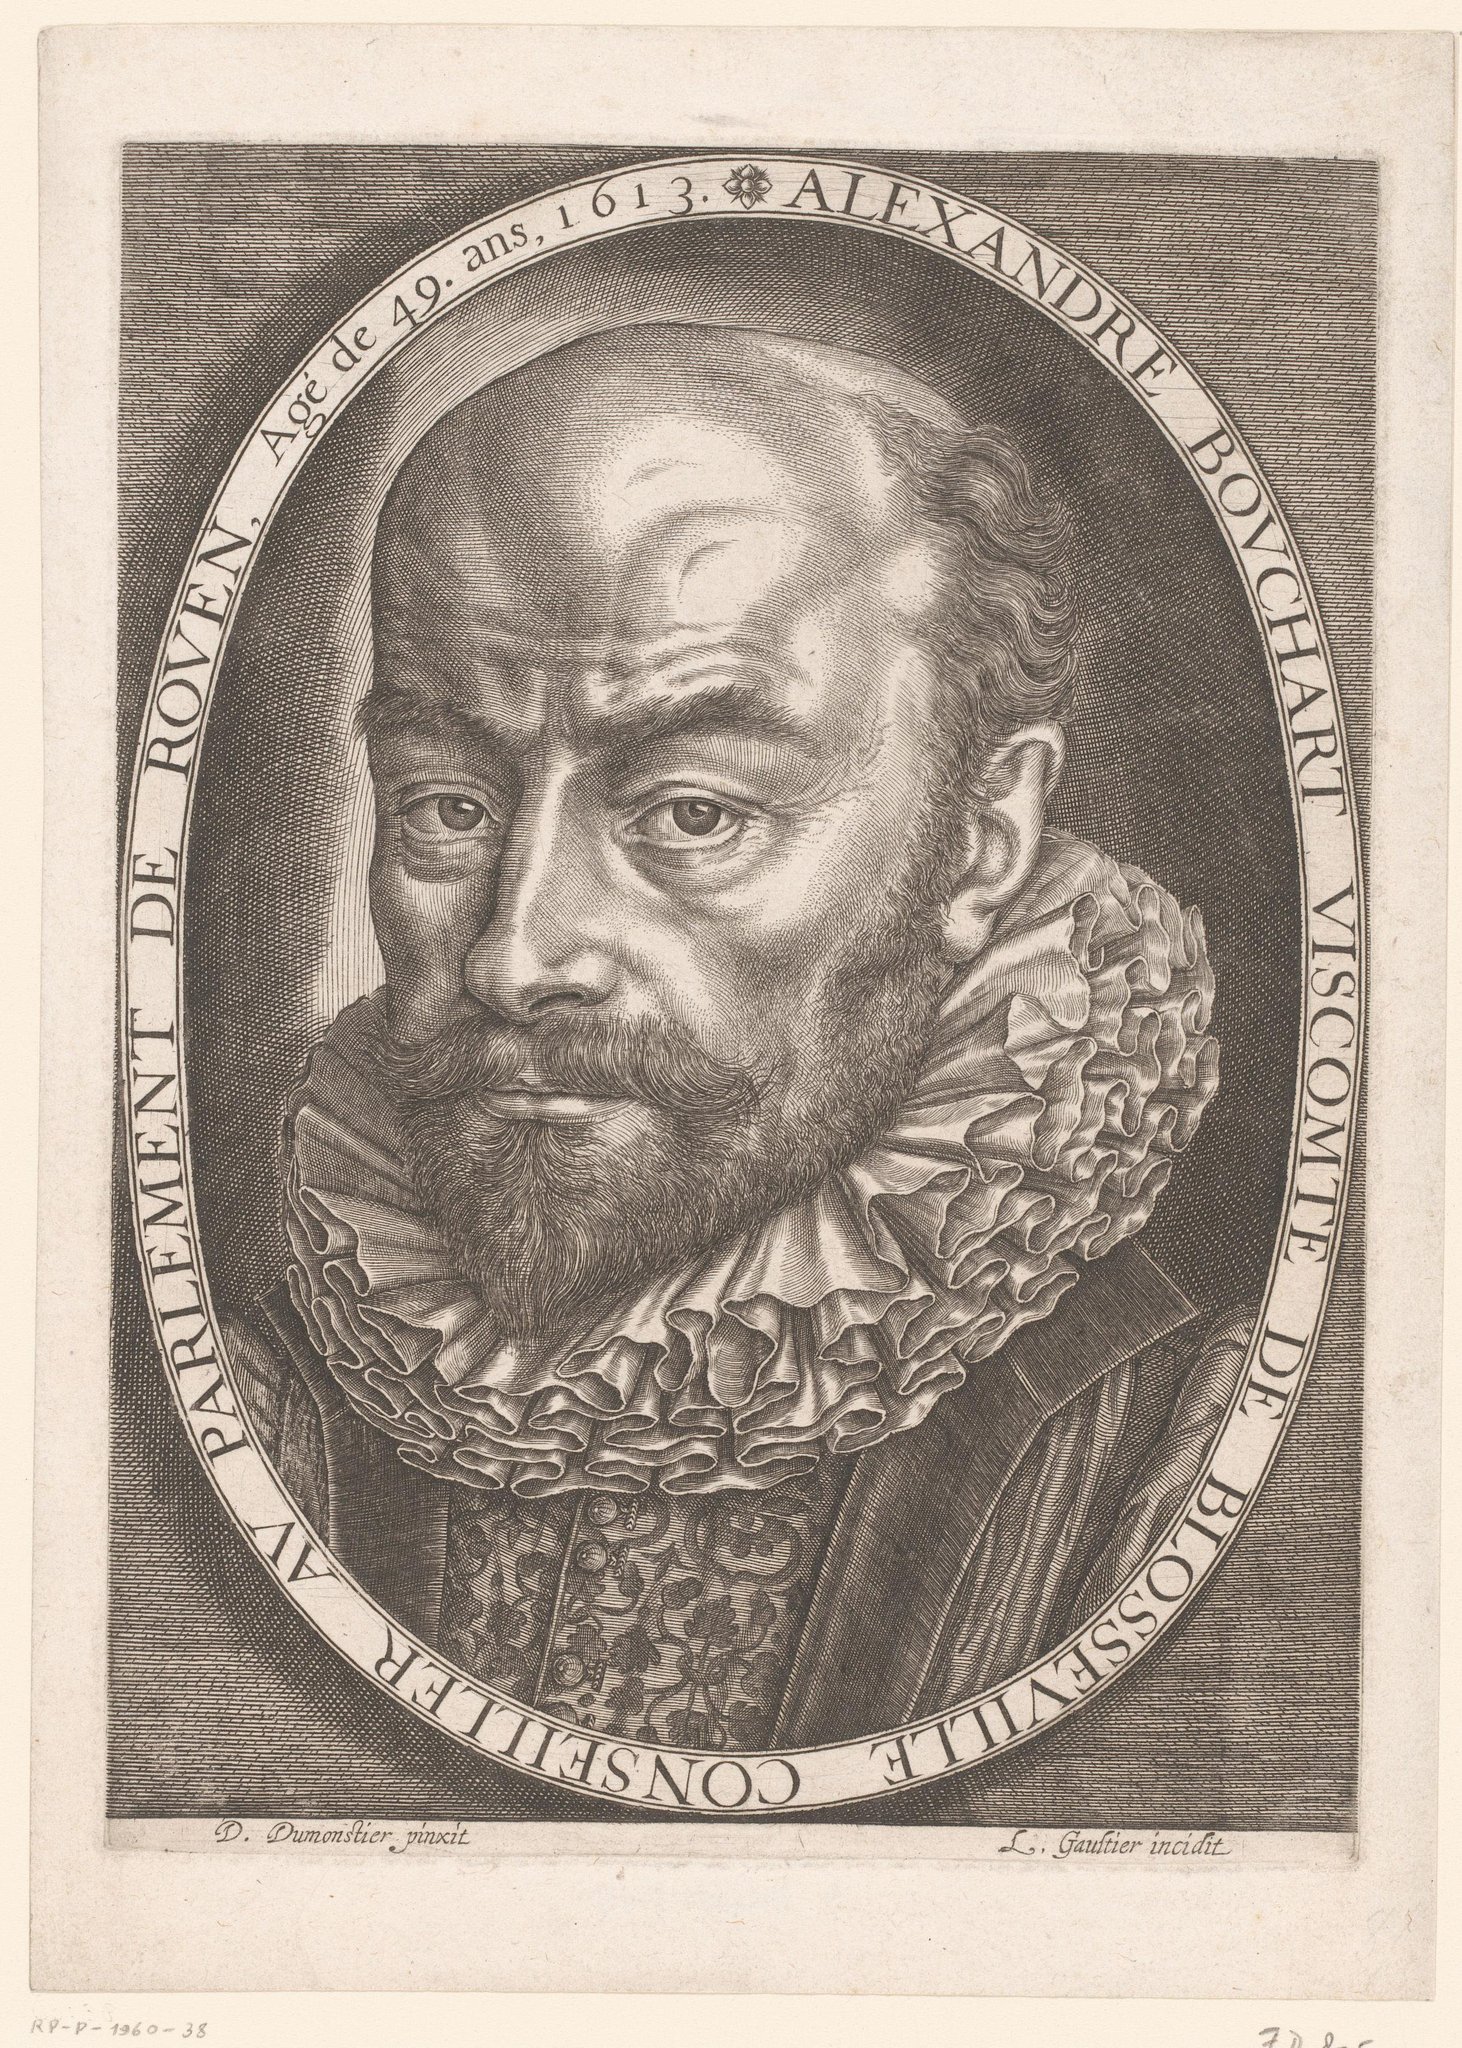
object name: print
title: Alexandre Bouchart viscomte de Blosseville conseilier au parlement de Rouen, Agé de 49. ans, 1613.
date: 1613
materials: paper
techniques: engraving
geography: france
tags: ornament ~ medallion, historical persons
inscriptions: collector's mark: Lugt 2228